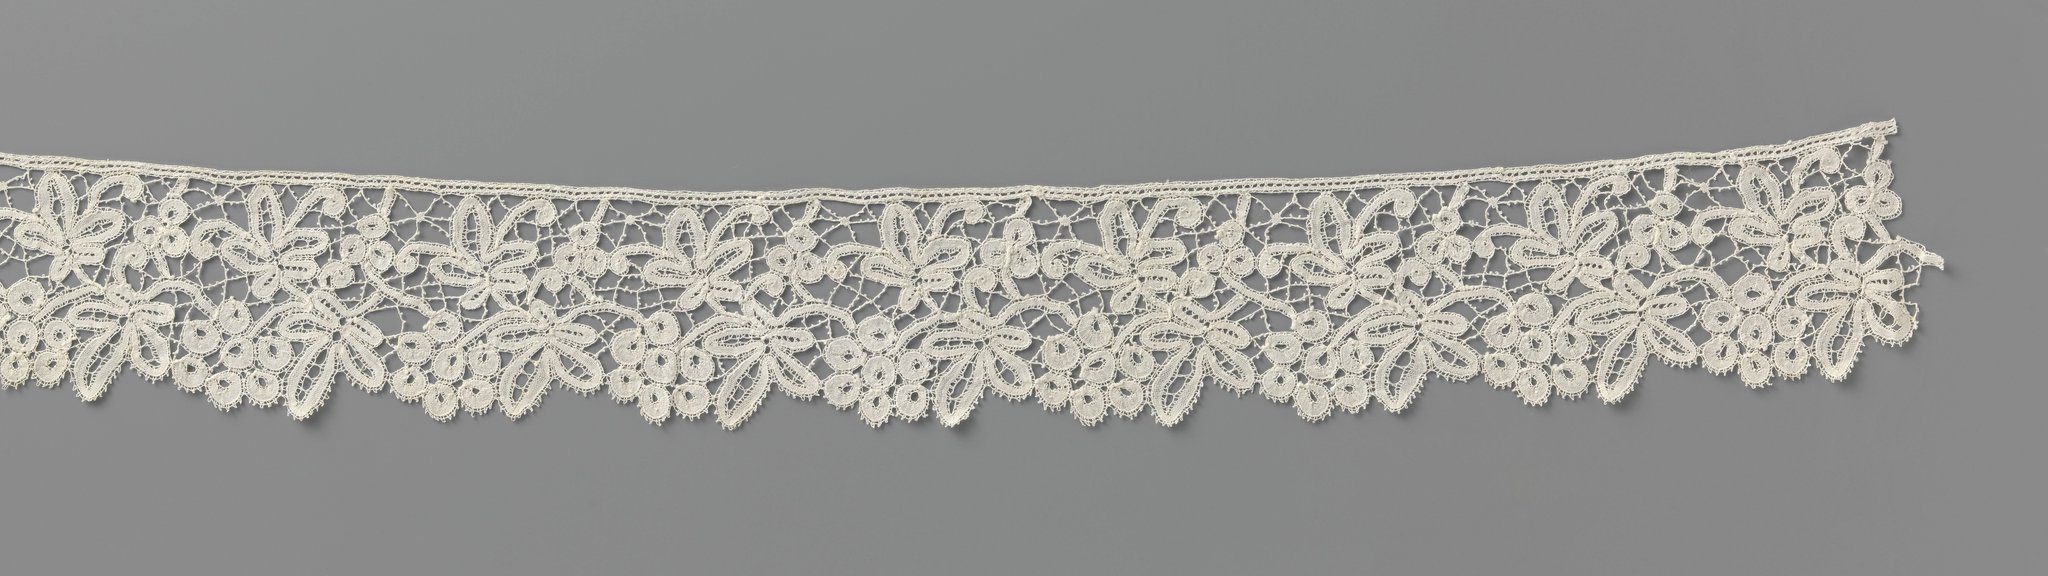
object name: strip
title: Strook kloskant met de druiventrossen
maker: Anonymous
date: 1875-1899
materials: linen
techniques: lace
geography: netherlands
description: Strook naturelkleurige kloskant: duchesse-kant. Op een open vlechtengrond staat een lopend patroon van een korte tak met twee wingerdbladeren en een druiventros. Om beurten vormen een blad en de tros de ongelijke schulpen.